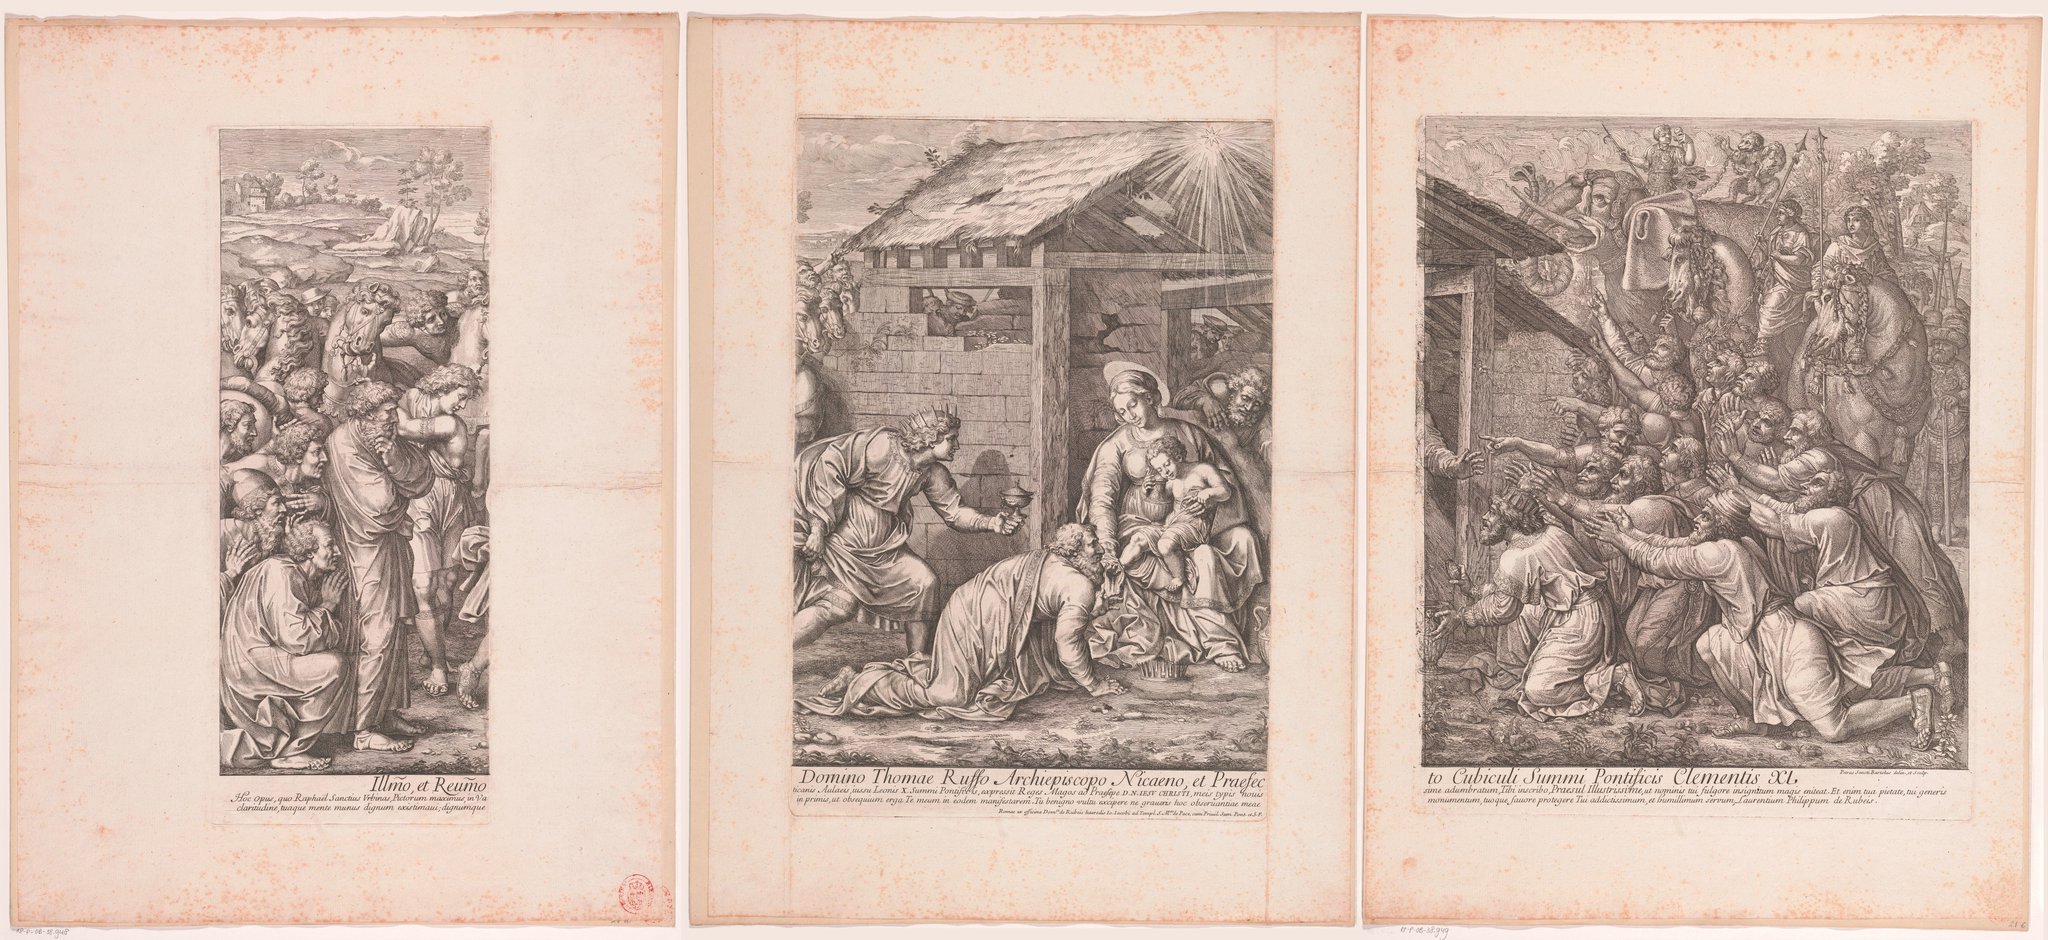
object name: print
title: Aanbidding door de koningen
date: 1645-1700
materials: paper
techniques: etching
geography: vatican city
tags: adoration of the kings: the wise men present their gifts to the christ-child (gold, frankincense and myrrh)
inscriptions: collector's mark: Lugt 240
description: De Heilige Familie zittend in een stal. Rondom de stal staan en knielen de drie koningen met hun gevolg in aanbidding van het Christuskind.